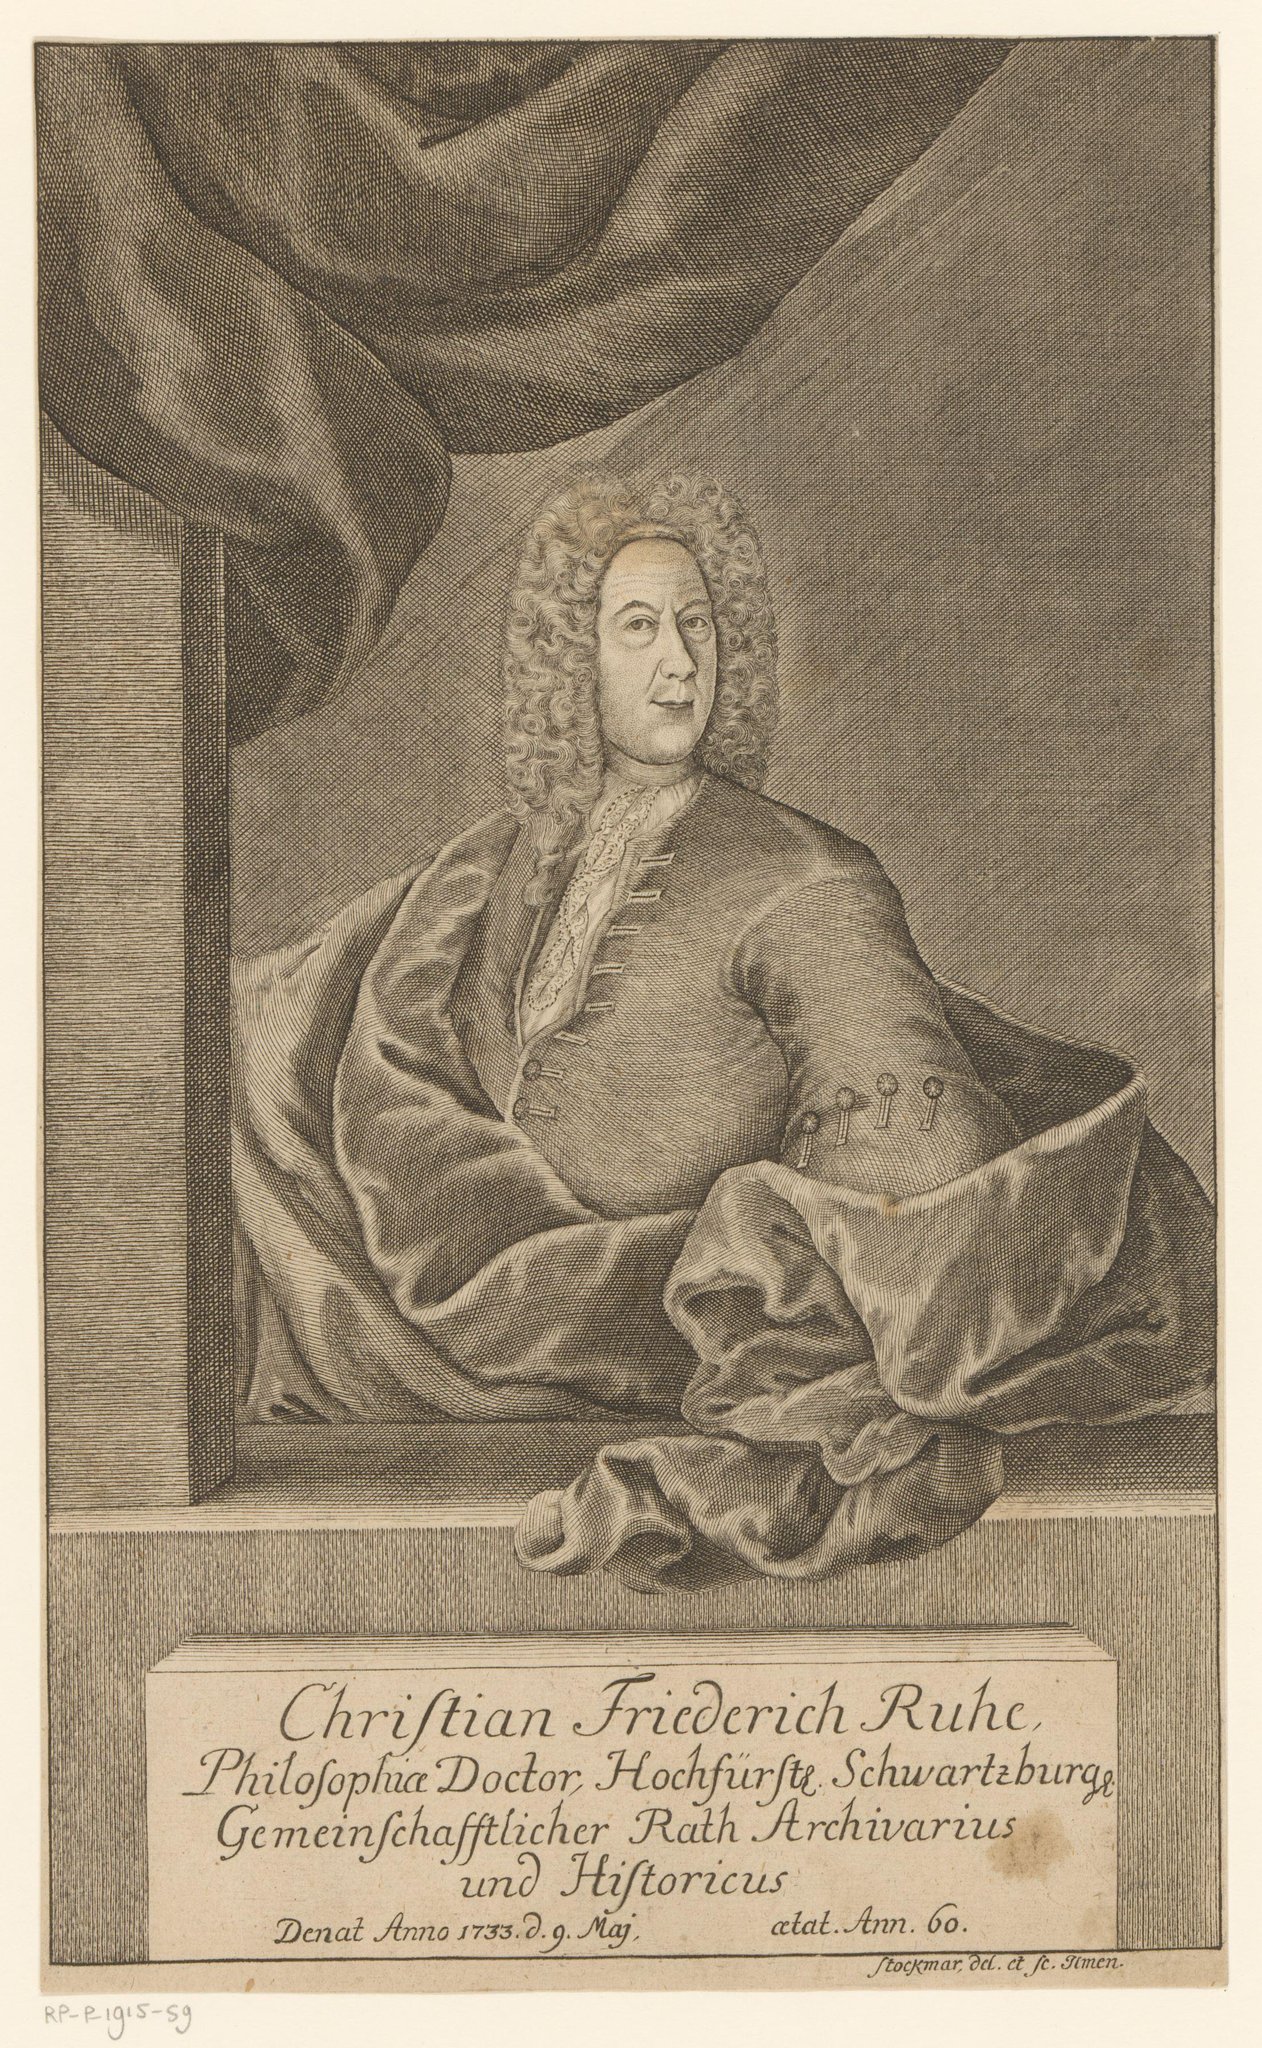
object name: print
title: Portret van Christian Friedrich Ruhe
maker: johann wolfgang heinrich stockmar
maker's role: print maker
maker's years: 1707-1785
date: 1733-1785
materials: paper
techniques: engraving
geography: ilmenau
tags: historical persons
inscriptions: collector's mark: Lugt 2228